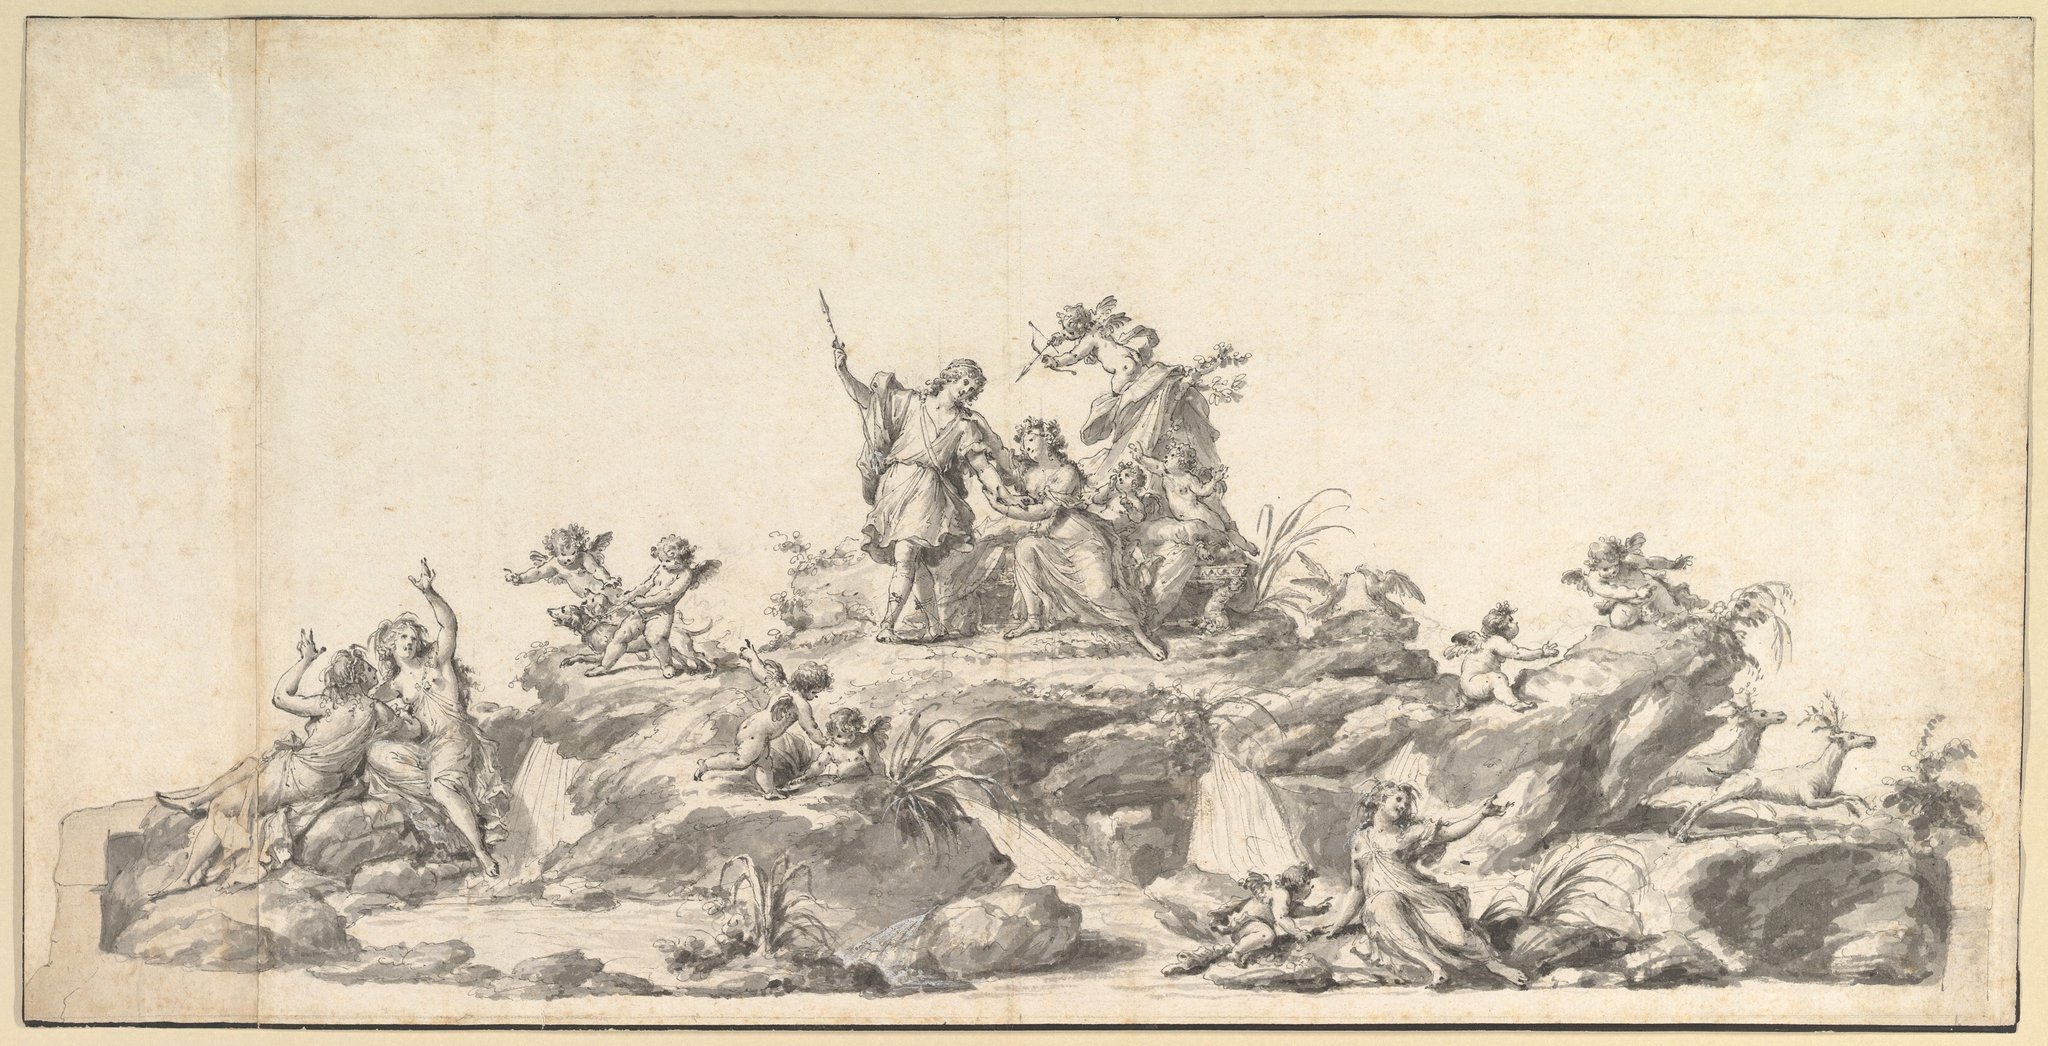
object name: drawing collection ornament architecture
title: Design for the Fontana di Venere e Adone, Reggia di Caserta, Naples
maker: fedele fischetti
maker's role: artist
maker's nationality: italian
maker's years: 1732-1792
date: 1780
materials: chalk, ink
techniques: pen, wash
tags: fountains,cupid,adonis,venus,deer